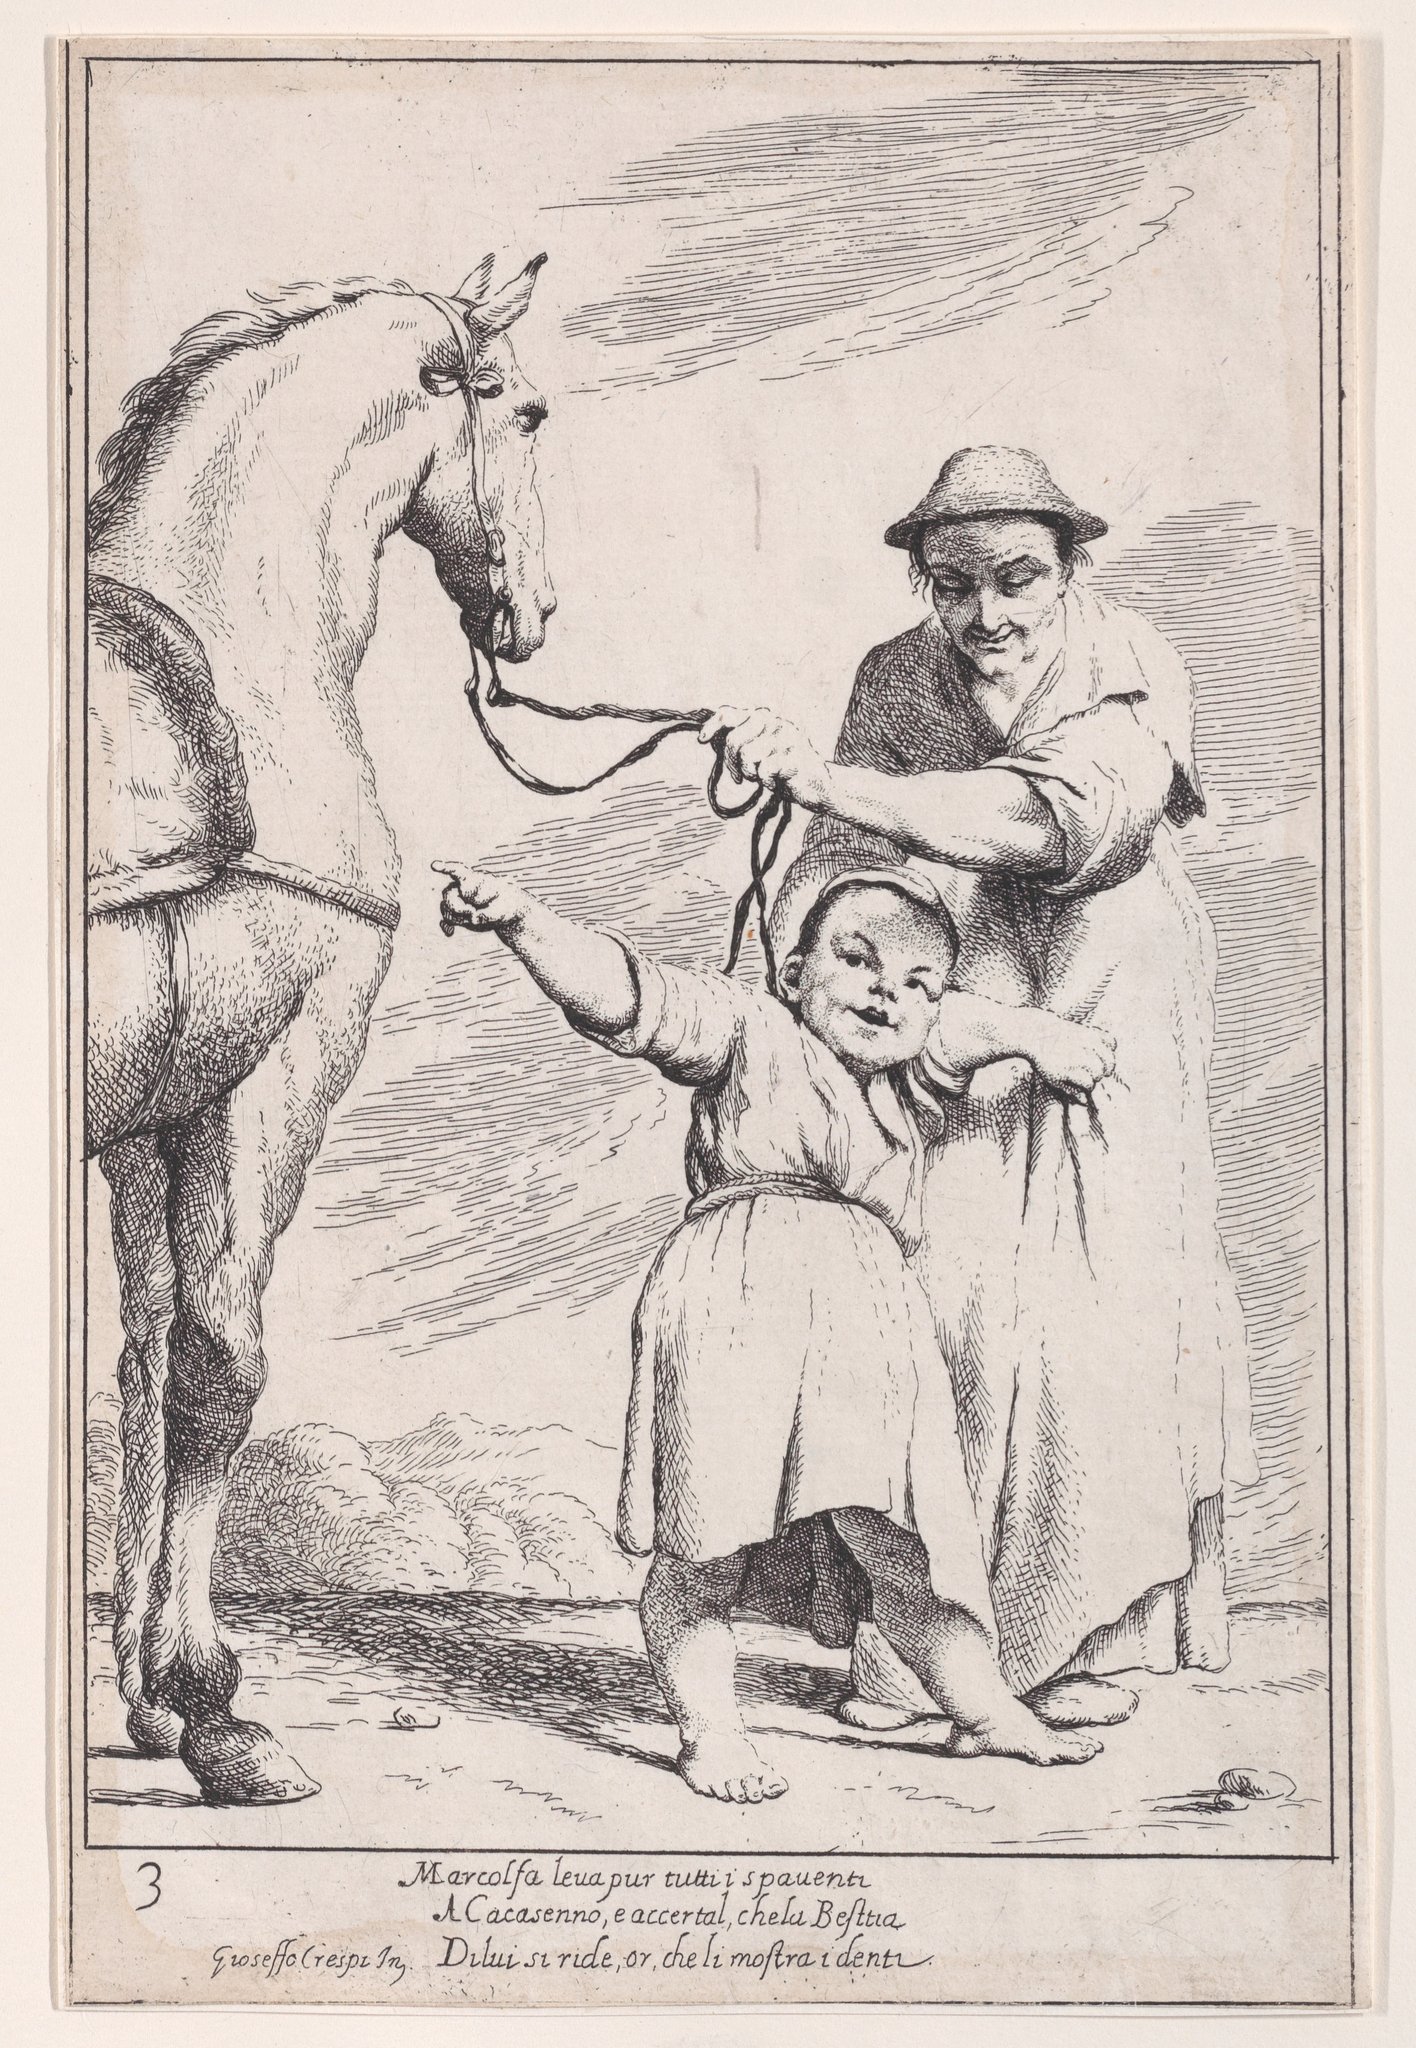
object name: print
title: Plate 17: Marcolfa shows Cacasenno a horse, from "Bertoldo, Bertoldino, and Cacasenno"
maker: giuseppe maria crespi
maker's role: artist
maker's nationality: italian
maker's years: 1665-1747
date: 1705-1715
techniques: etching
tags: children,women,horses